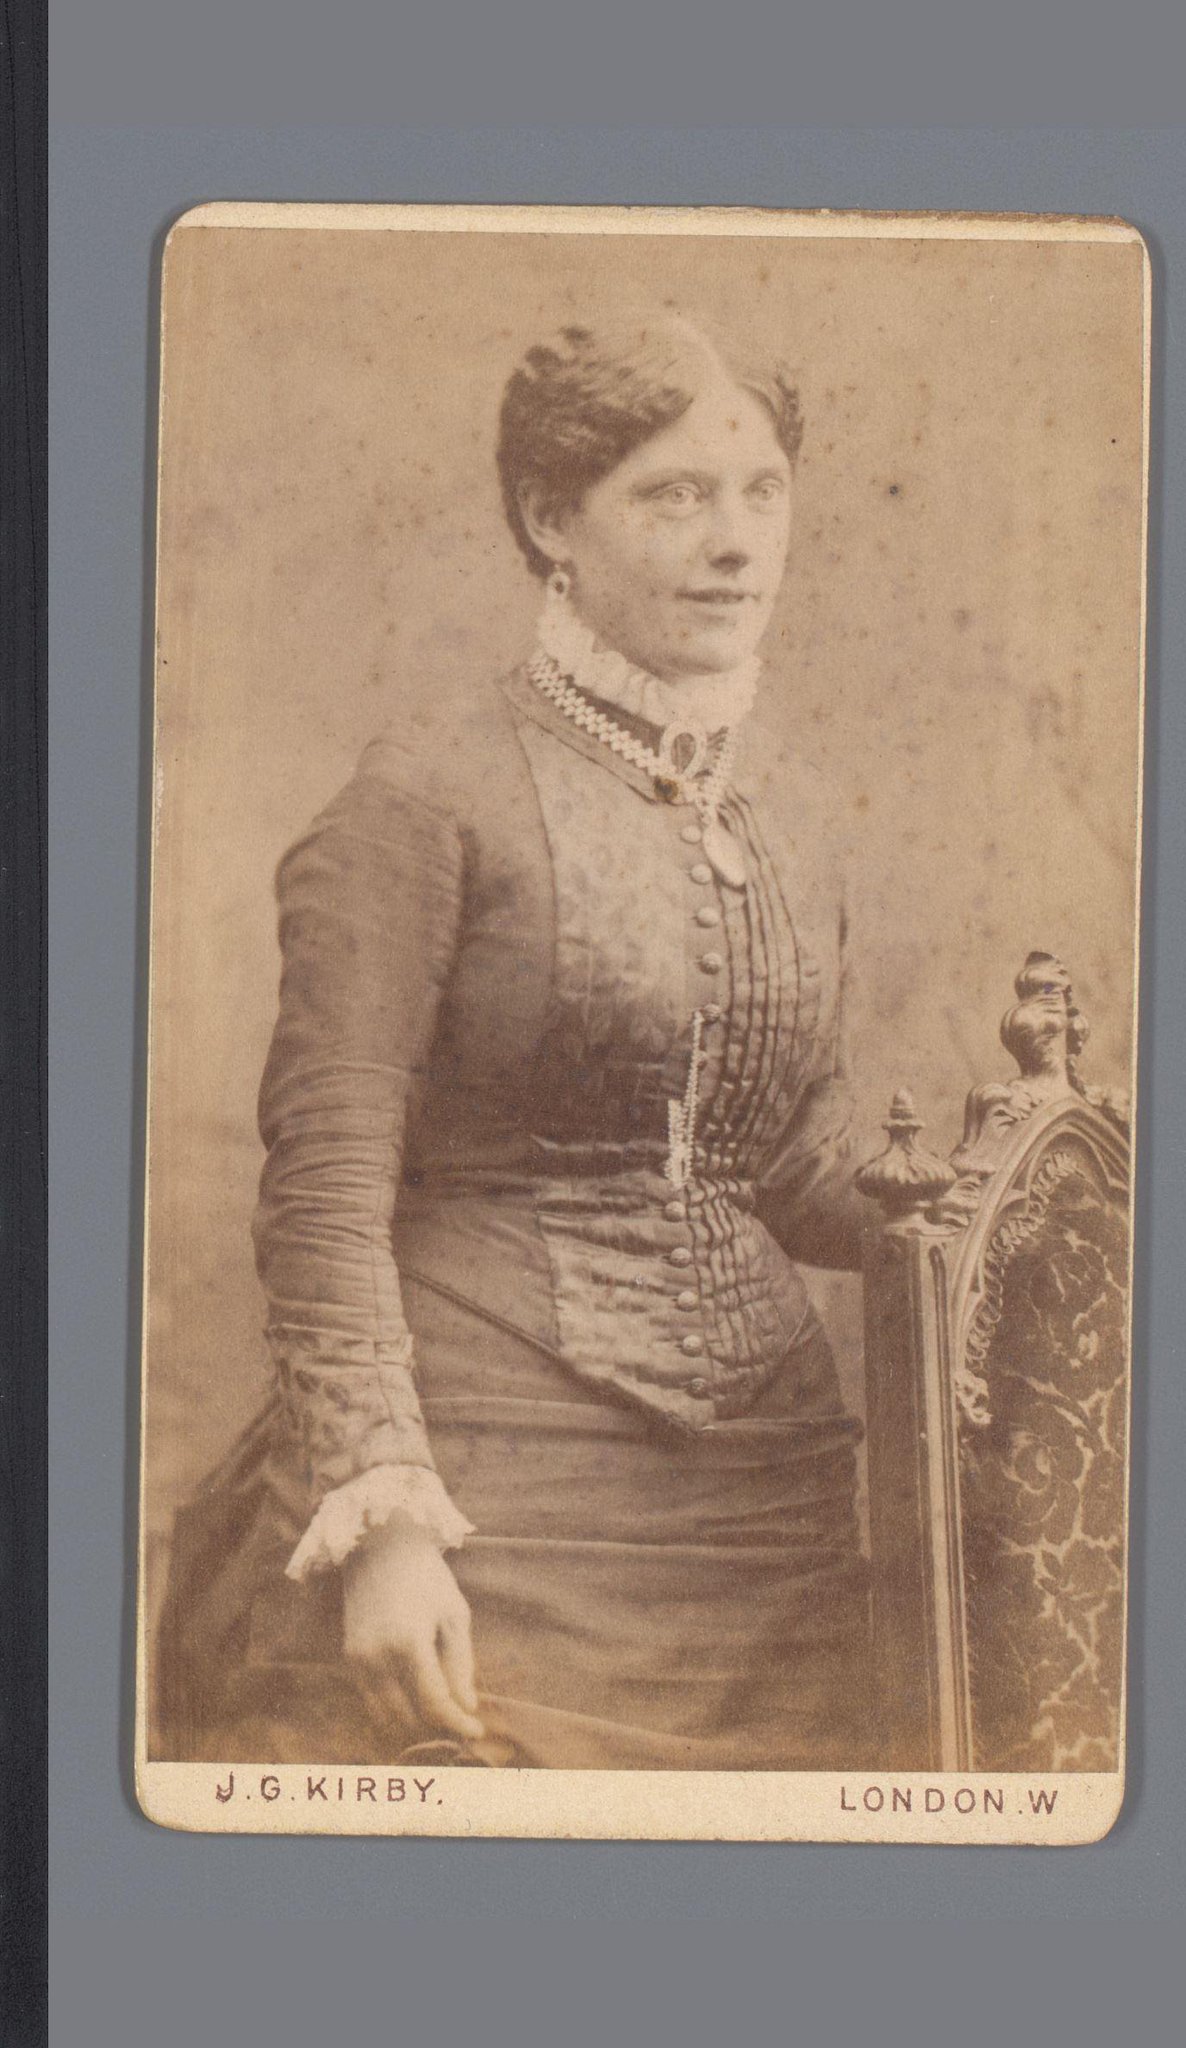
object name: photograph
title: Portret van een onbekende vrouw bij een stoel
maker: john george kirby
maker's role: fotograaf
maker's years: 1849-1913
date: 1855-1885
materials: cardboard, paper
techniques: albumen print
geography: london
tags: adult woman, anonymous historical person portrayed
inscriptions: address: ‘295, Edgware Road/ W./ LONDON.’, inscription: ‘Negatives kept. Copies or Enlargements/ can be had at any time.’